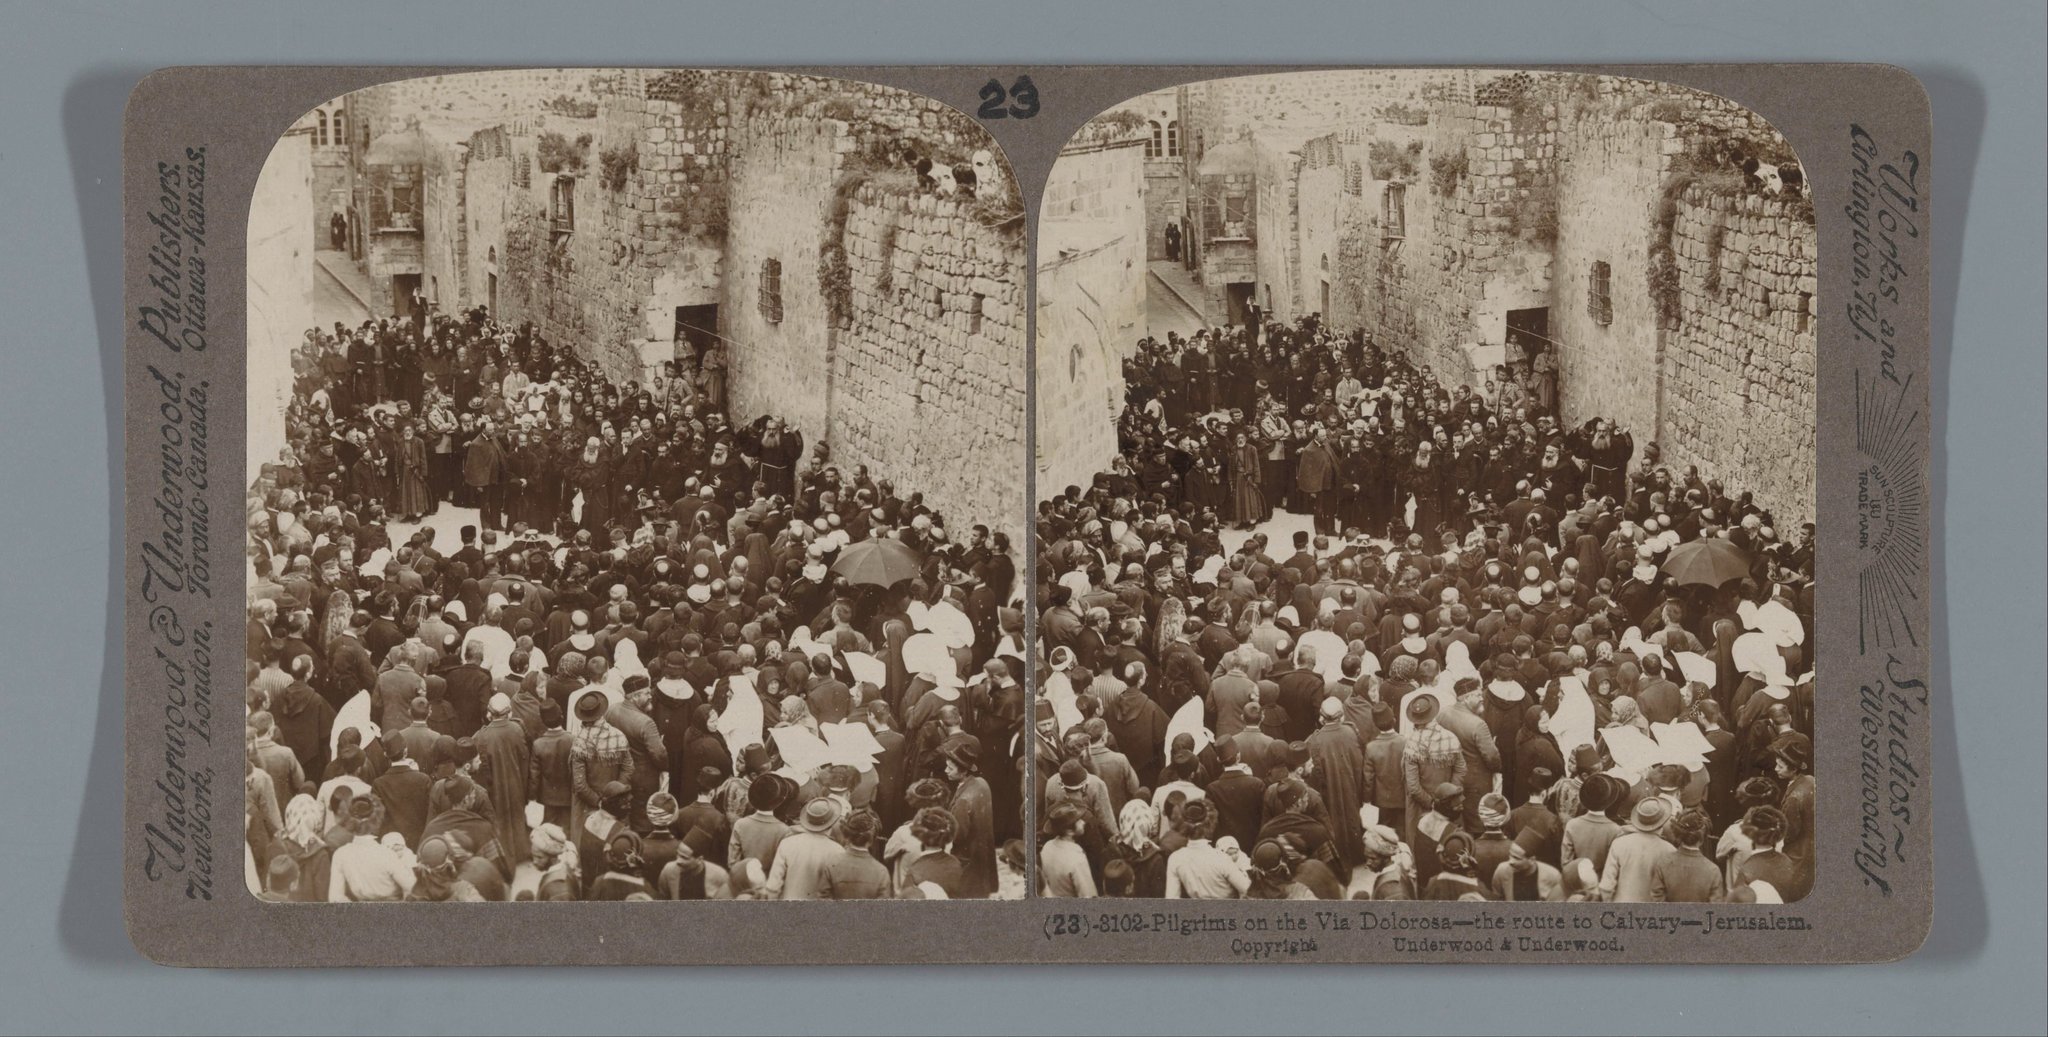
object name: stereograph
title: Pilgrims on the Via Dolorosa - the route to Calvary - Jerusalem.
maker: Anonymous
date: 1900-1905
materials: paper, cardboard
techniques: gelatin silver print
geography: new york city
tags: pilgrim(s) - qq - large group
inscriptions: inscription, number: ‘(23)-3102-’, number: ‘23’, inscription: ‘Works and Studios ~/ Arlington, N.J. Westwood, N.J.’, copyright notice: ‘Copyright Underwood & Underwood.’